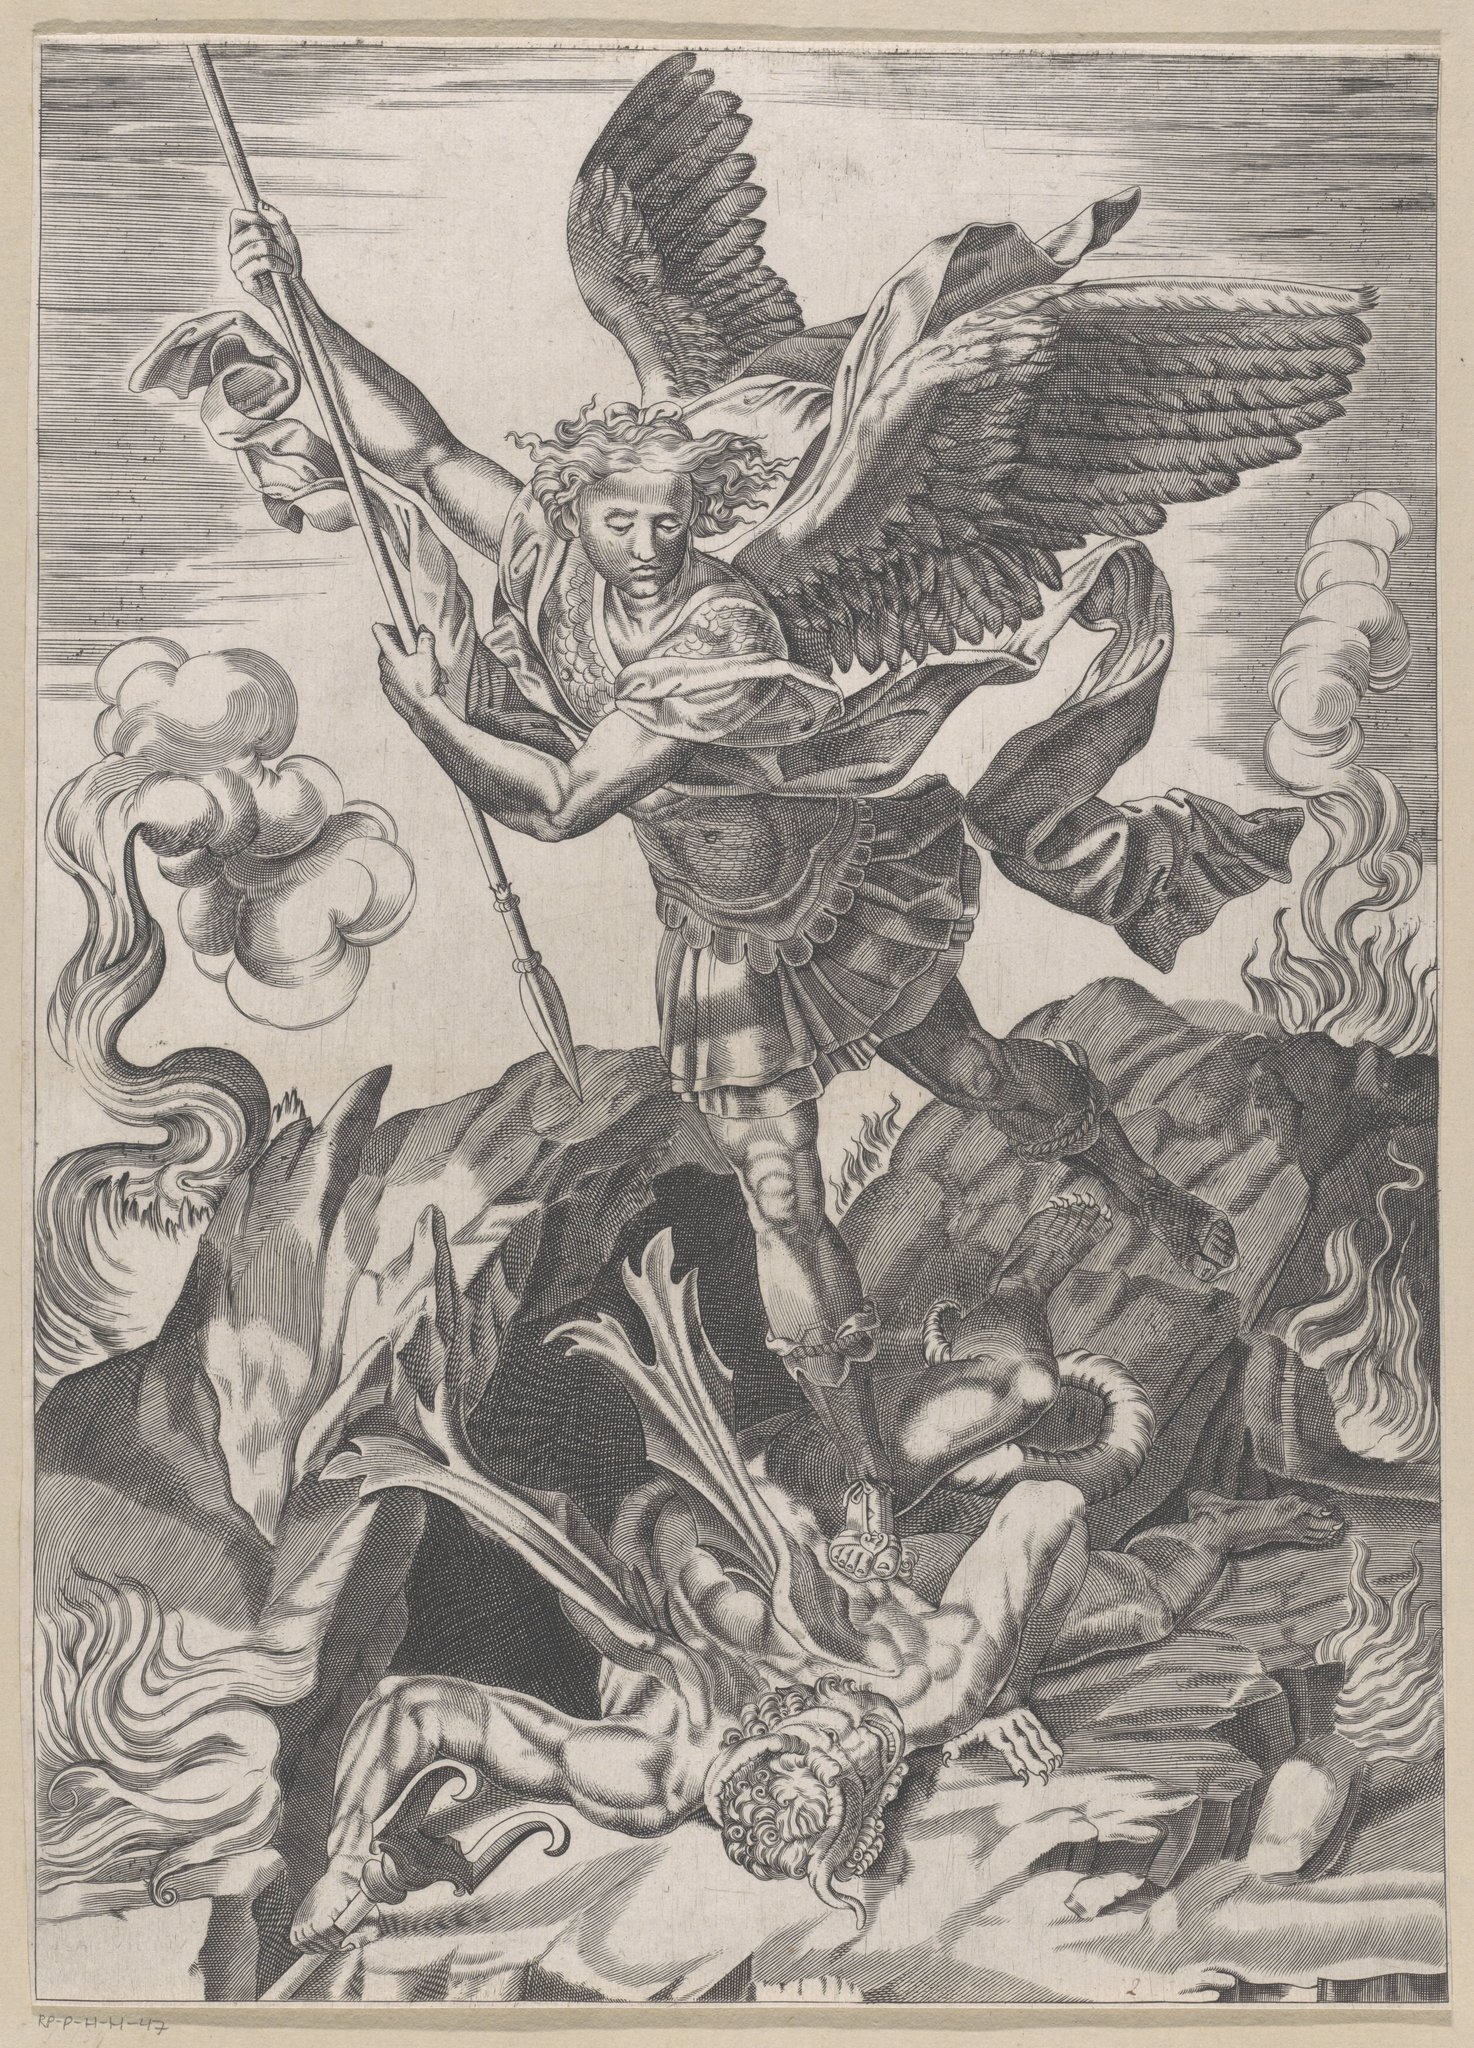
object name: print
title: Michaël en de duivel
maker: nicolas beatrizet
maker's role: print maker, publisher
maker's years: 1507-1565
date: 1525-1565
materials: paper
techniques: engraving, etching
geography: italy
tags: the archangel michael fighting the dragon (devil, satan)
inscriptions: collector's mark: Lugt 10, collector's mark: Lugt 11, collector's mark: ‘Hinloopen’, number: ‘2’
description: De aartsengel Michaël steekt de duivel neer met een speer.